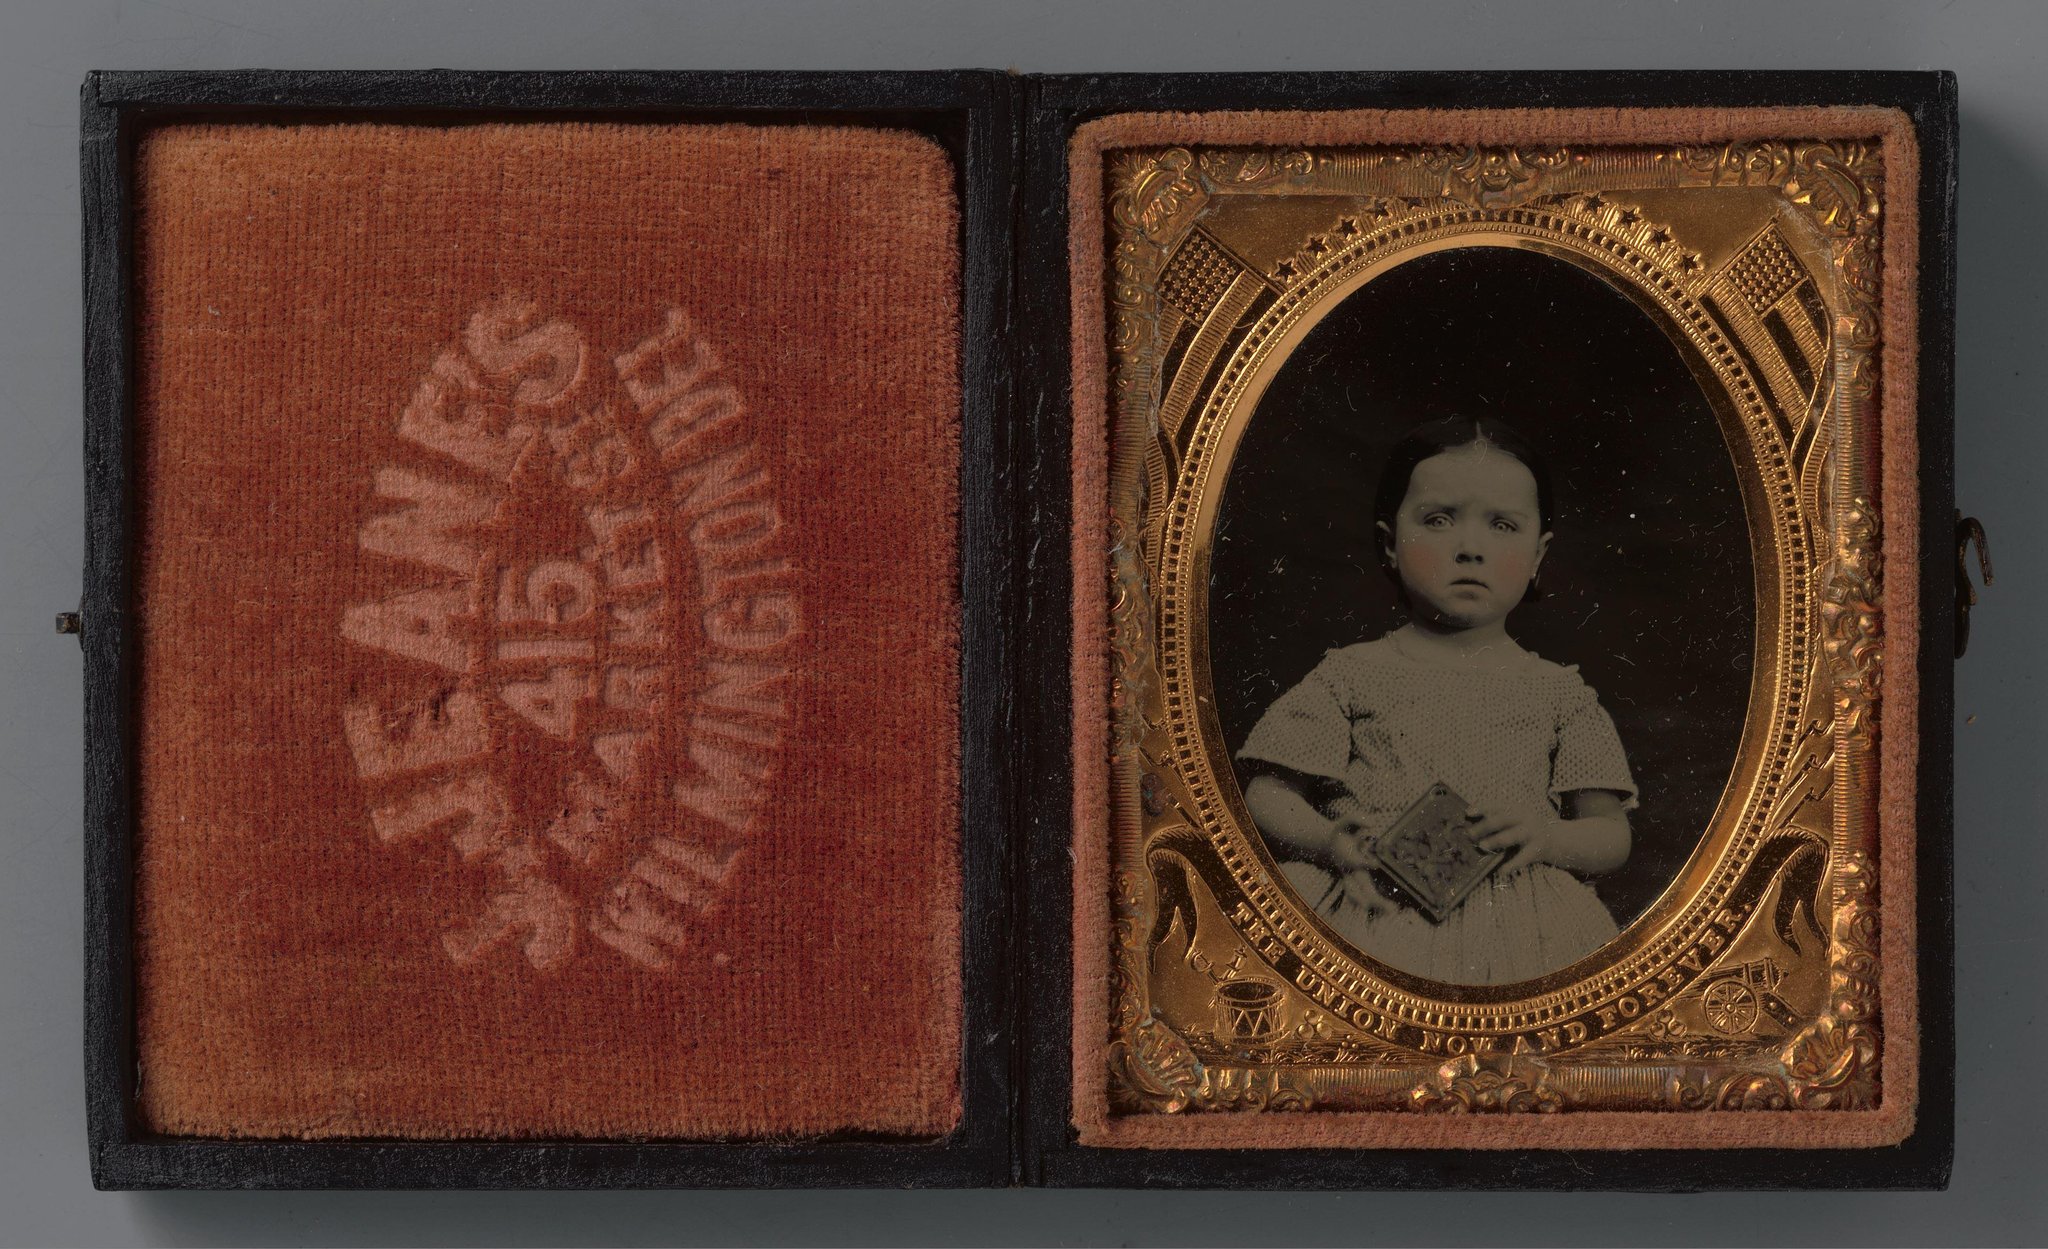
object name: photograph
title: Portret van een onbekend meisje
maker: j. jeanne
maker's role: fotograaf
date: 1855-1870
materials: glass, metal, plastic, velvet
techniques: ambrotype, hand coloring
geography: wilmington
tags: historical persons - bb - woman, toddler (female)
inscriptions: inscription: ‘J.JEANE'S/ 415/ MARKET ST., WILMINGTON DEL’